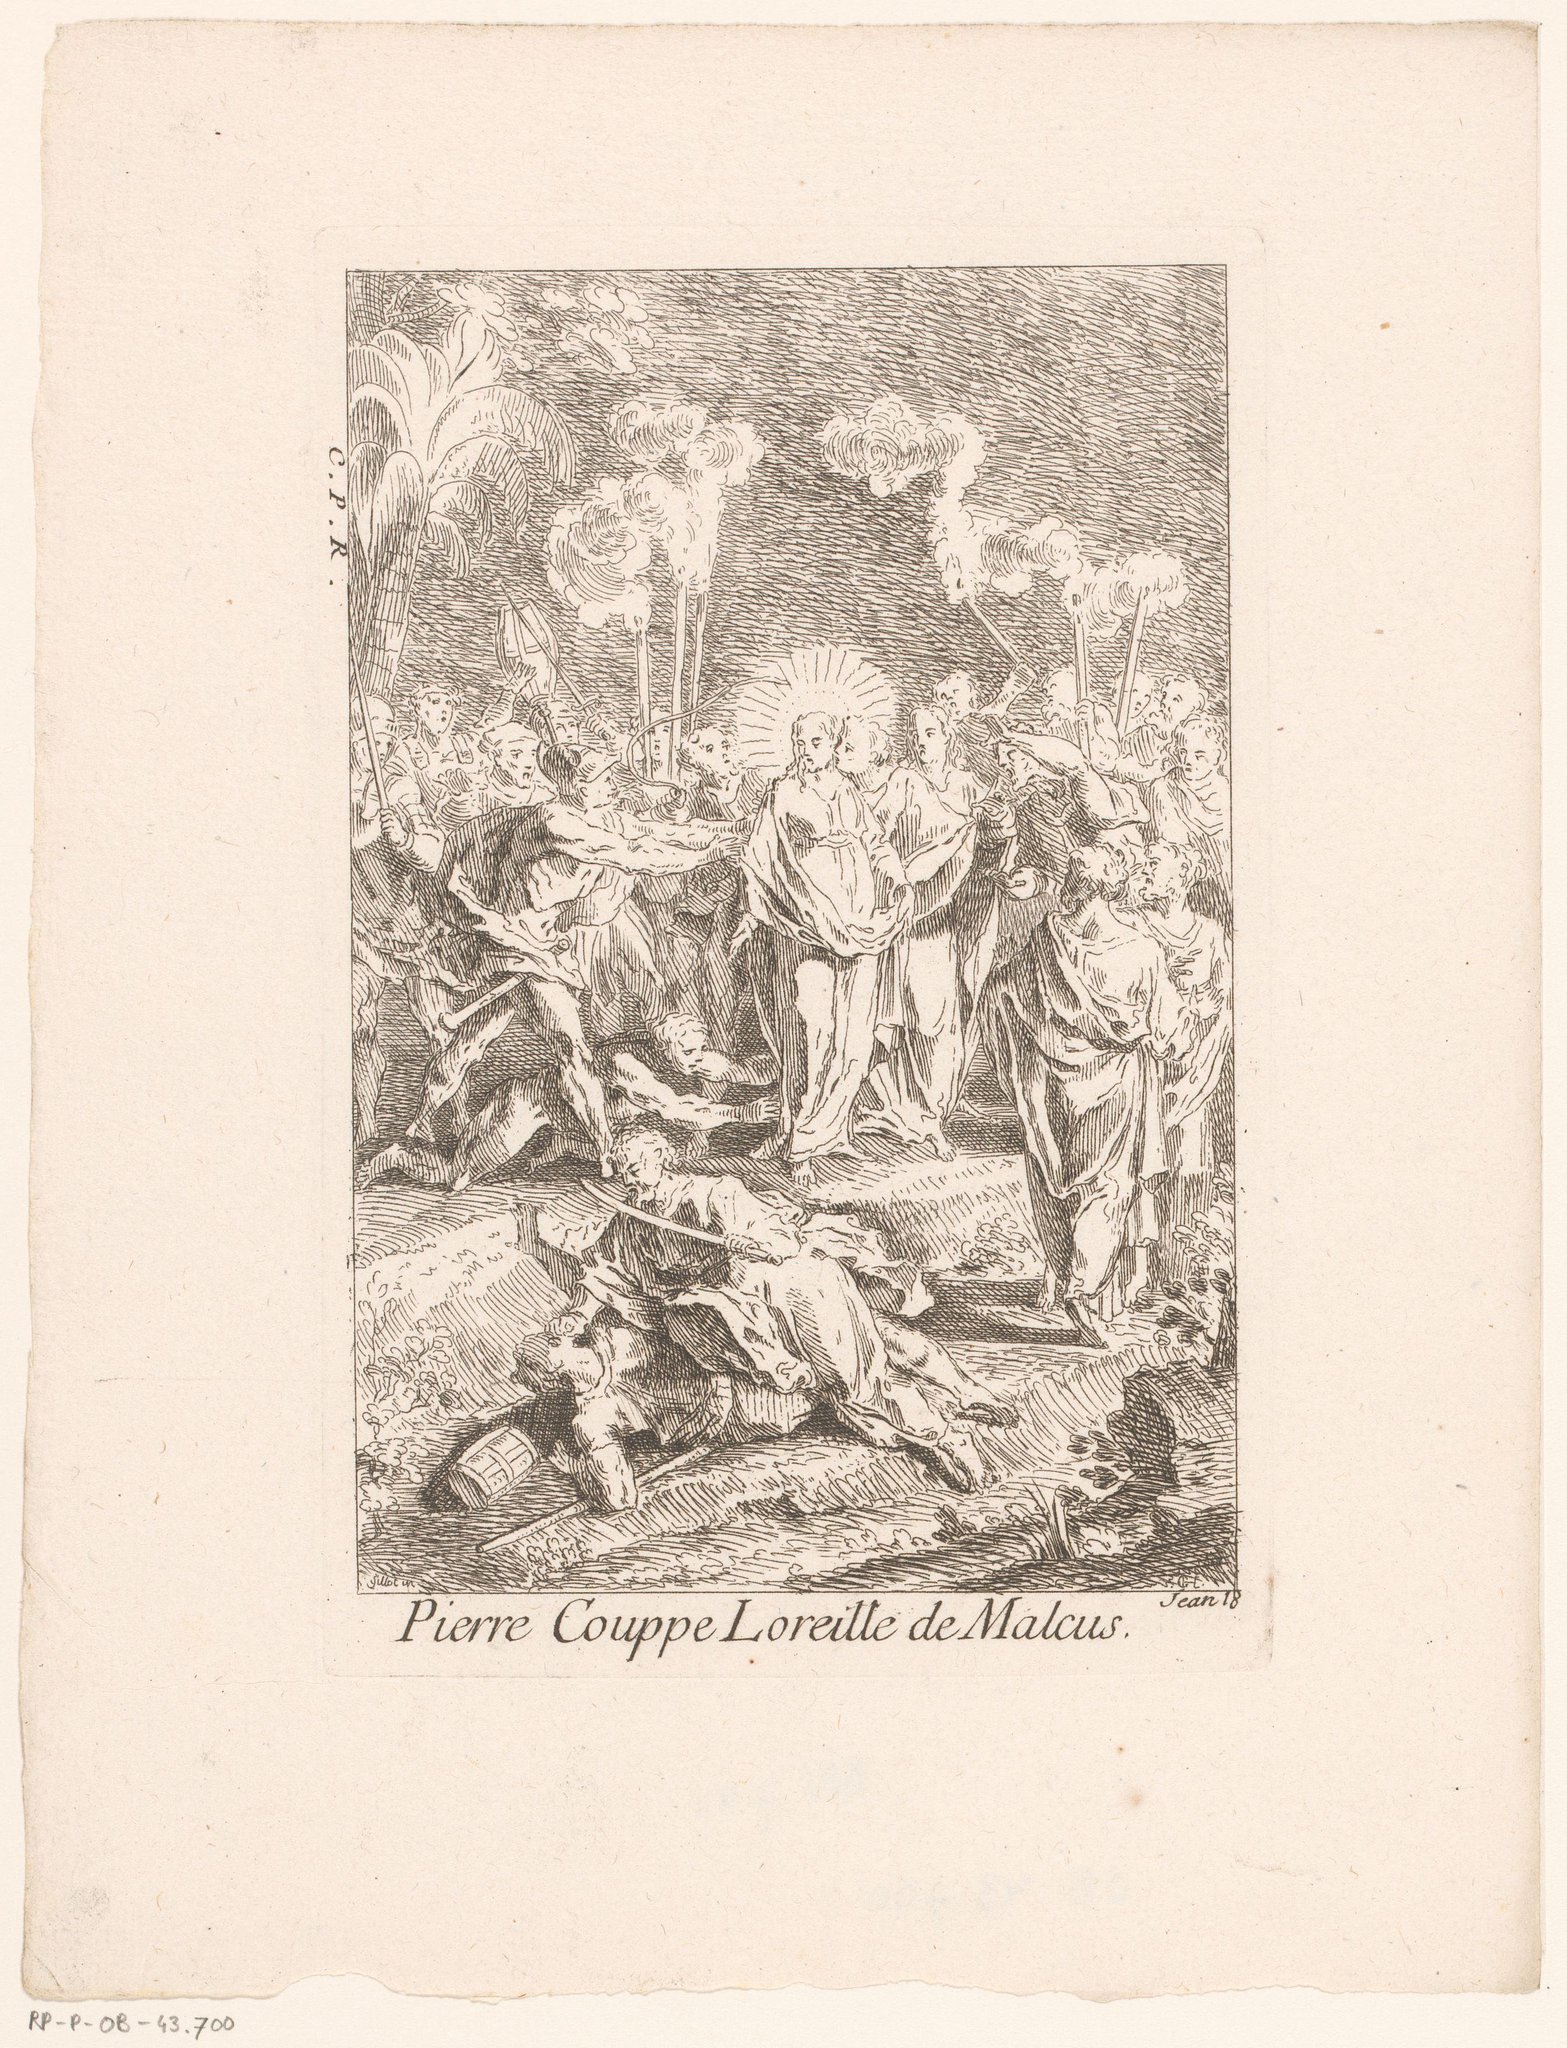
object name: print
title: Gevangenneming van Christus en Petrus hakt het oor van Malchus af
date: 1705-1732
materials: paper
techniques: etching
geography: france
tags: peter draws his sword and cuts off malchus' ear, the arrest of christ ~ garden of gethsemane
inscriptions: collector's mark: Lugt 2228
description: Maakt deel uit van een serie met zestig prenten met als thema het leven van Christus.